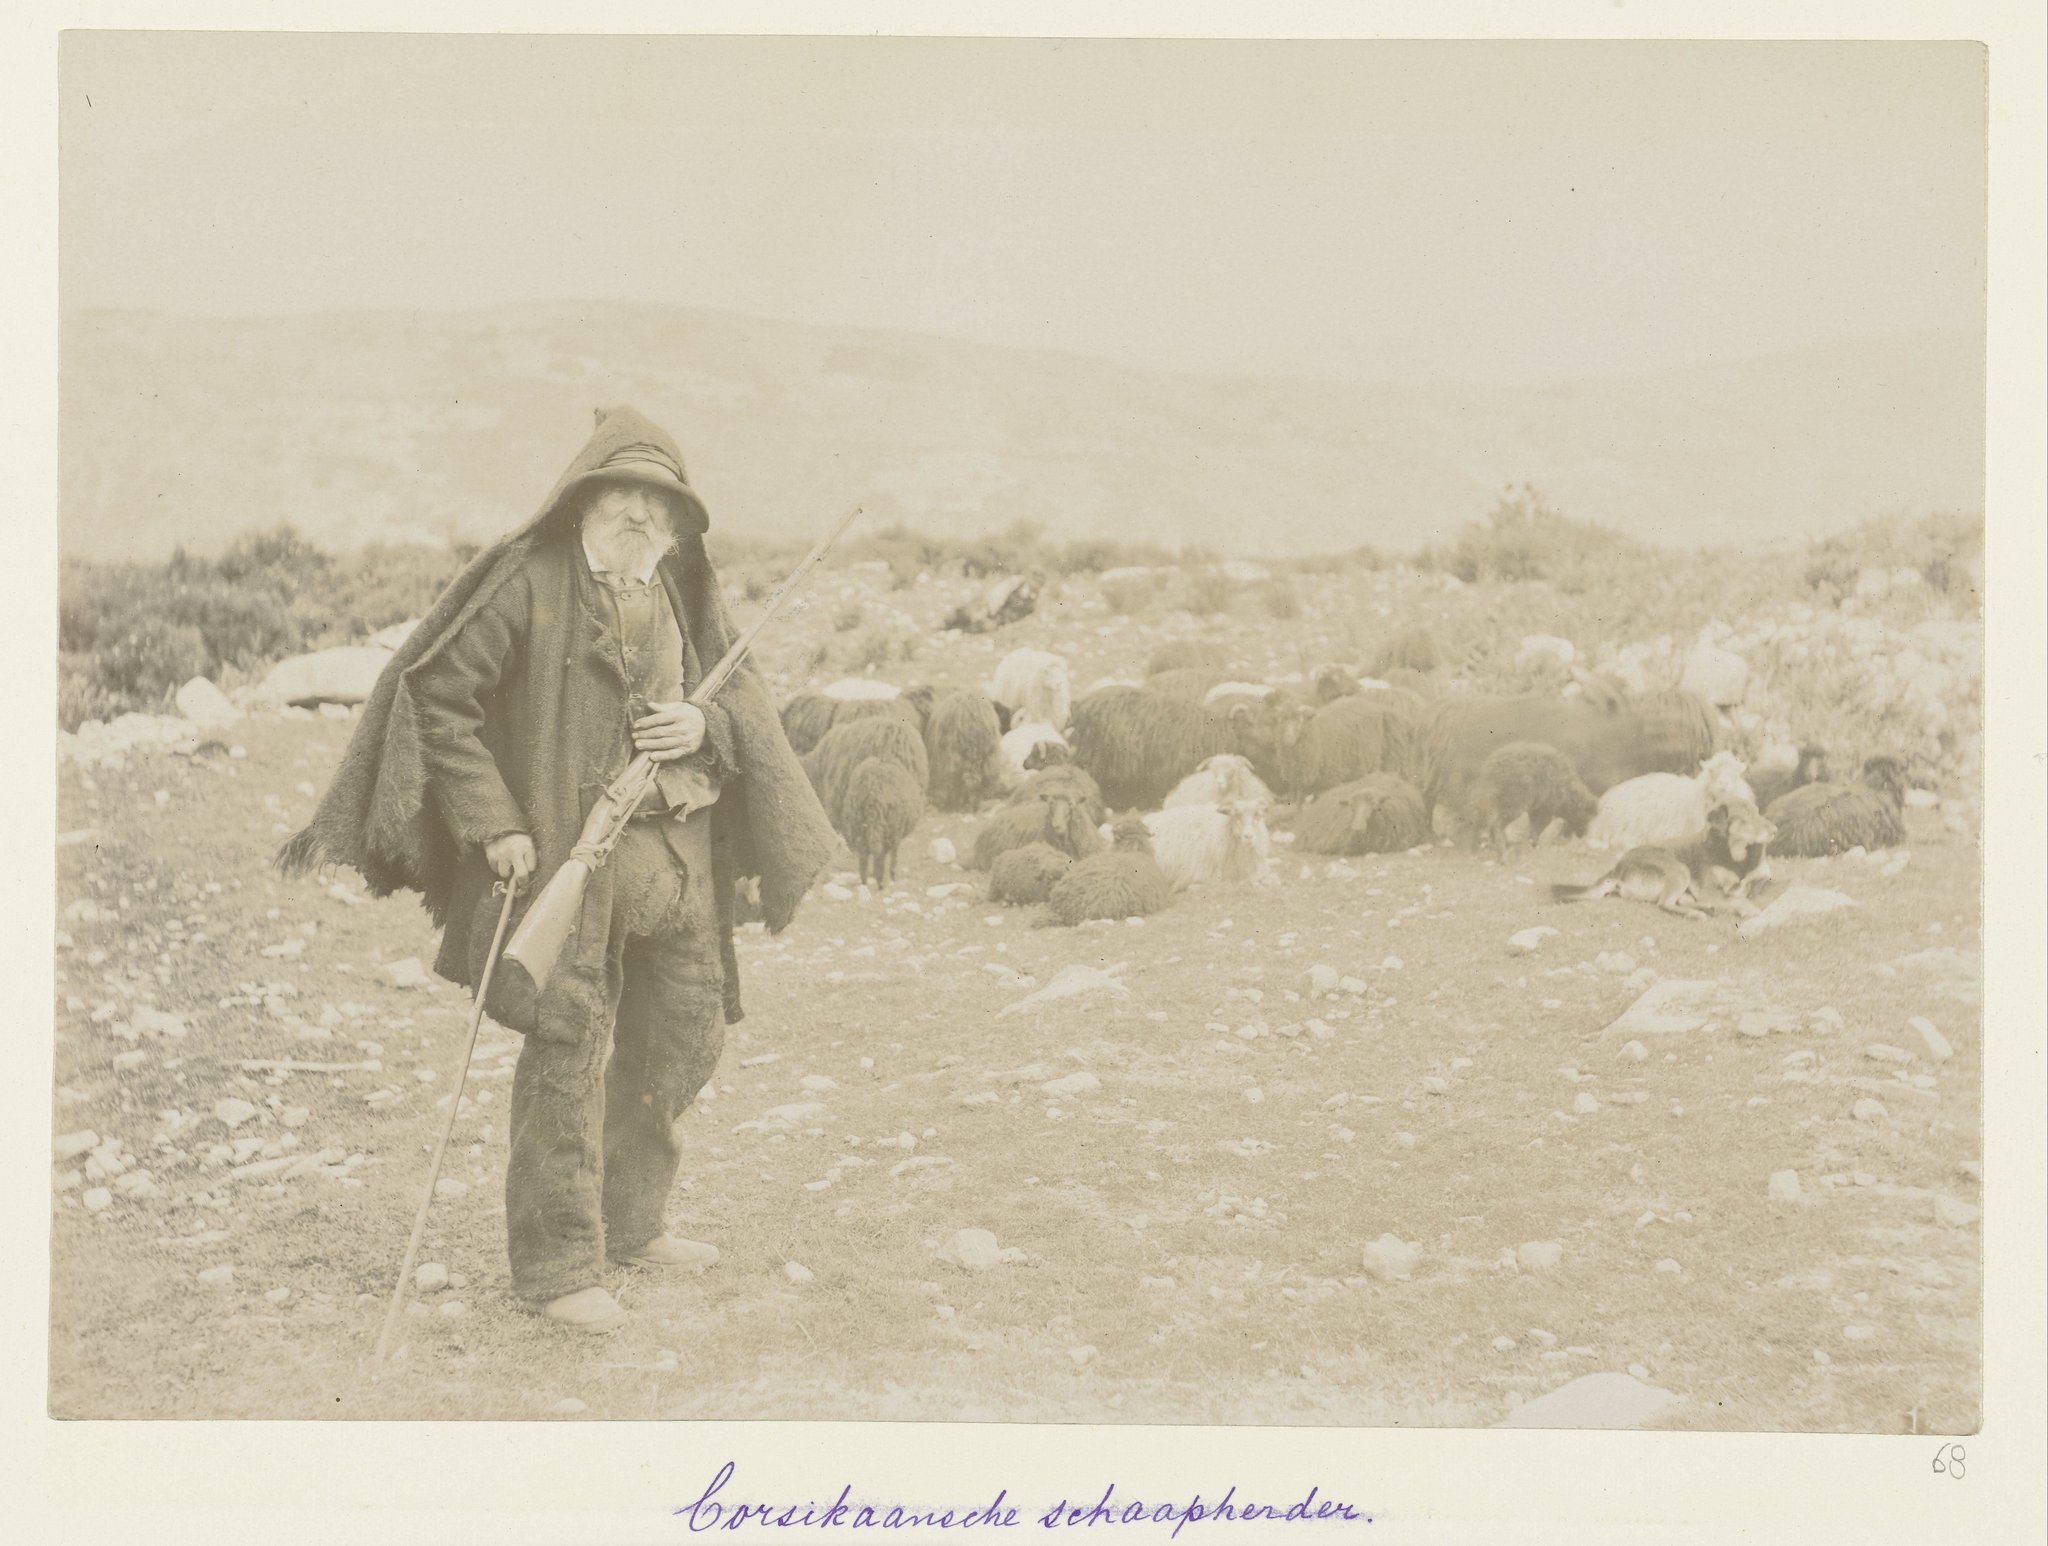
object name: photograph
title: Corsikaansche schapenherder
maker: henry pauw van wieldrecht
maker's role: fotograaf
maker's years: 1863-1912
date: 1886-1896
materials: cardboard, photographic support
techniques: albumen print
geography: corsica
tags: corsica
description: Een schapenherder met geweer bij een grote kudde schapen in het bergachtige Corsicaanse landschap.